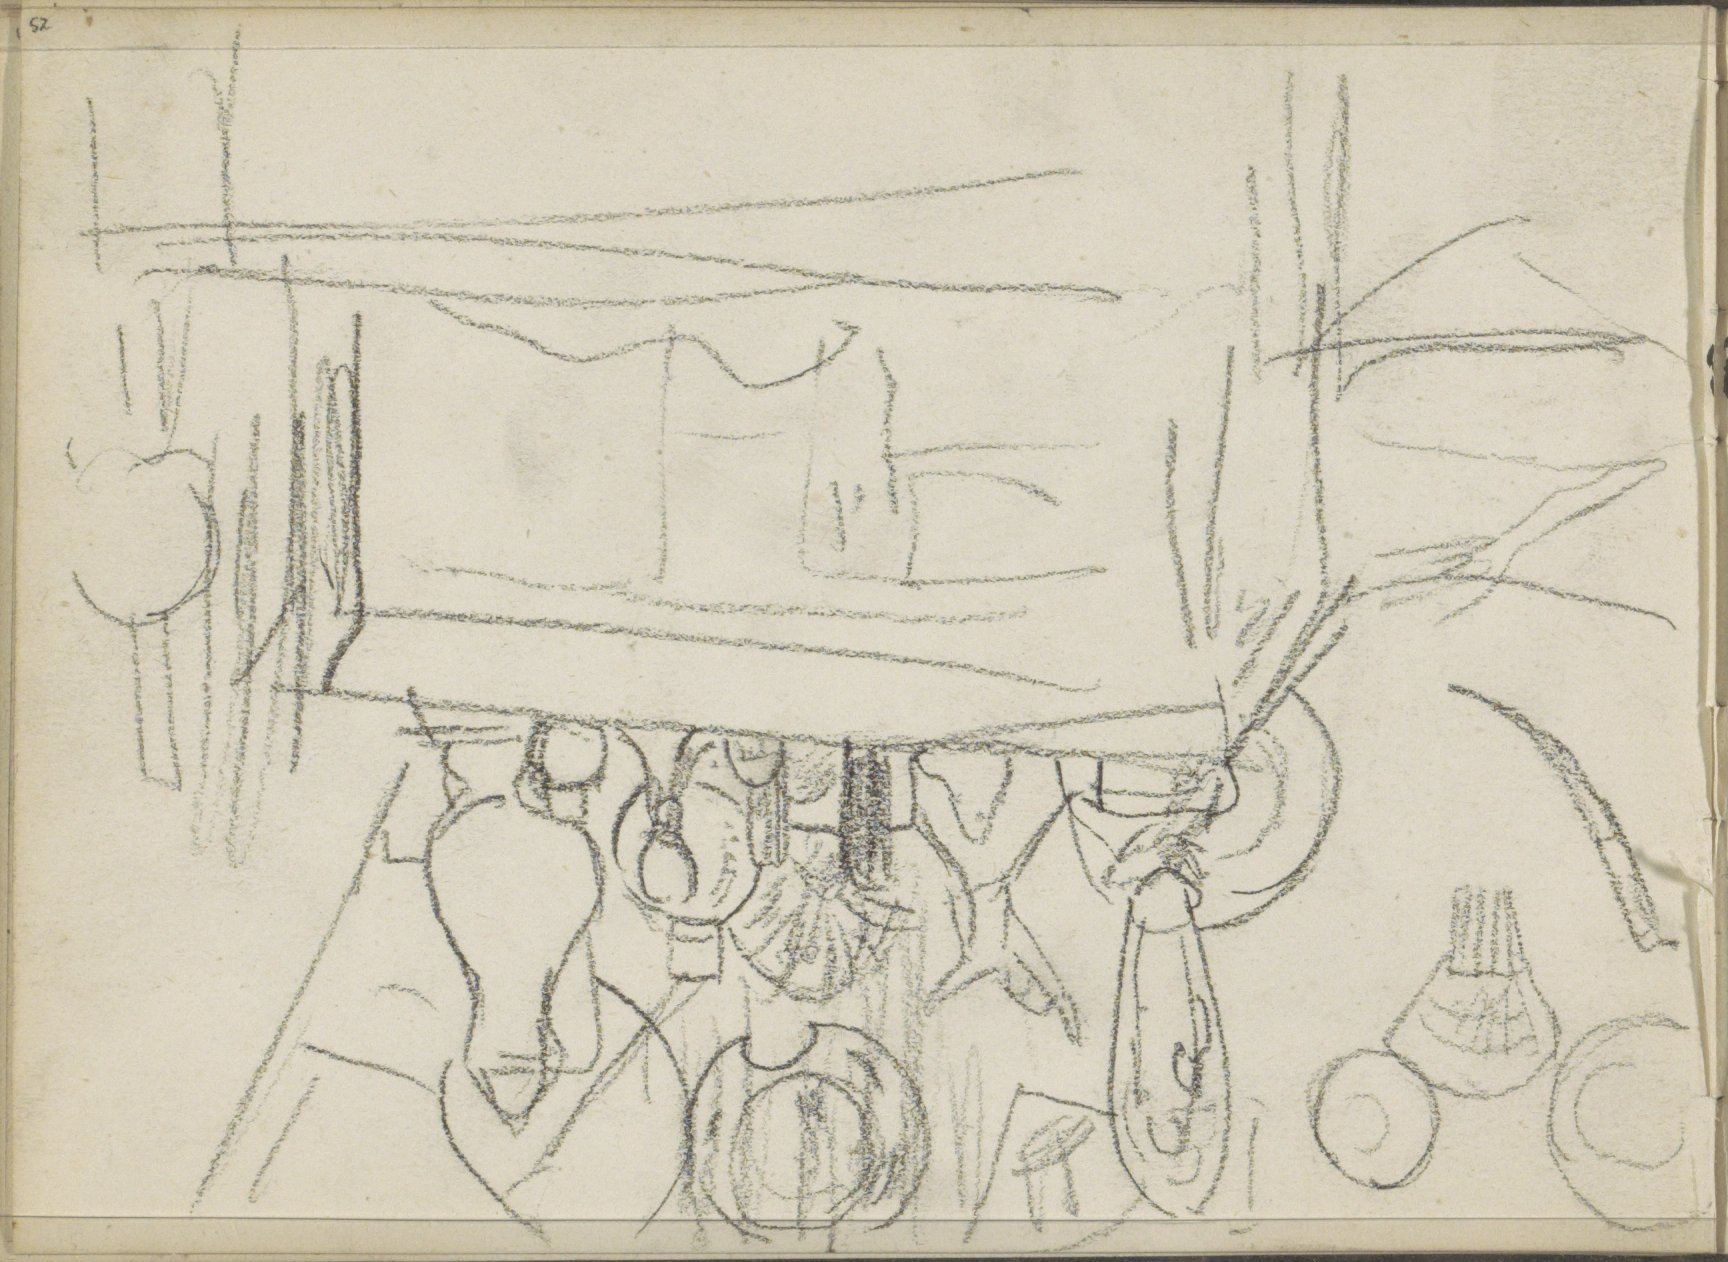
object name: sketchbook leaf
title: Schoorsteenmantel met objecten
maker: marius bauer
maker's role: draughtsman, print maker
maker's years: 1867-1932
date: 1877-1932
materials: chalk, paper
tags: fan, piece of sculpture, reproduction of a piece of sculpture, container of ceramics: jar, jug, pot, vase, dish, plate, saucer, chimney-piece, mantelpiece, candlestick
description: Op de schoorsteenmantel staan onder andere een vaas, kandelaars en een beeldje. Erboven hangen borden en waaiers. Pagina 52 uit een schetsboek met 32 bladen.